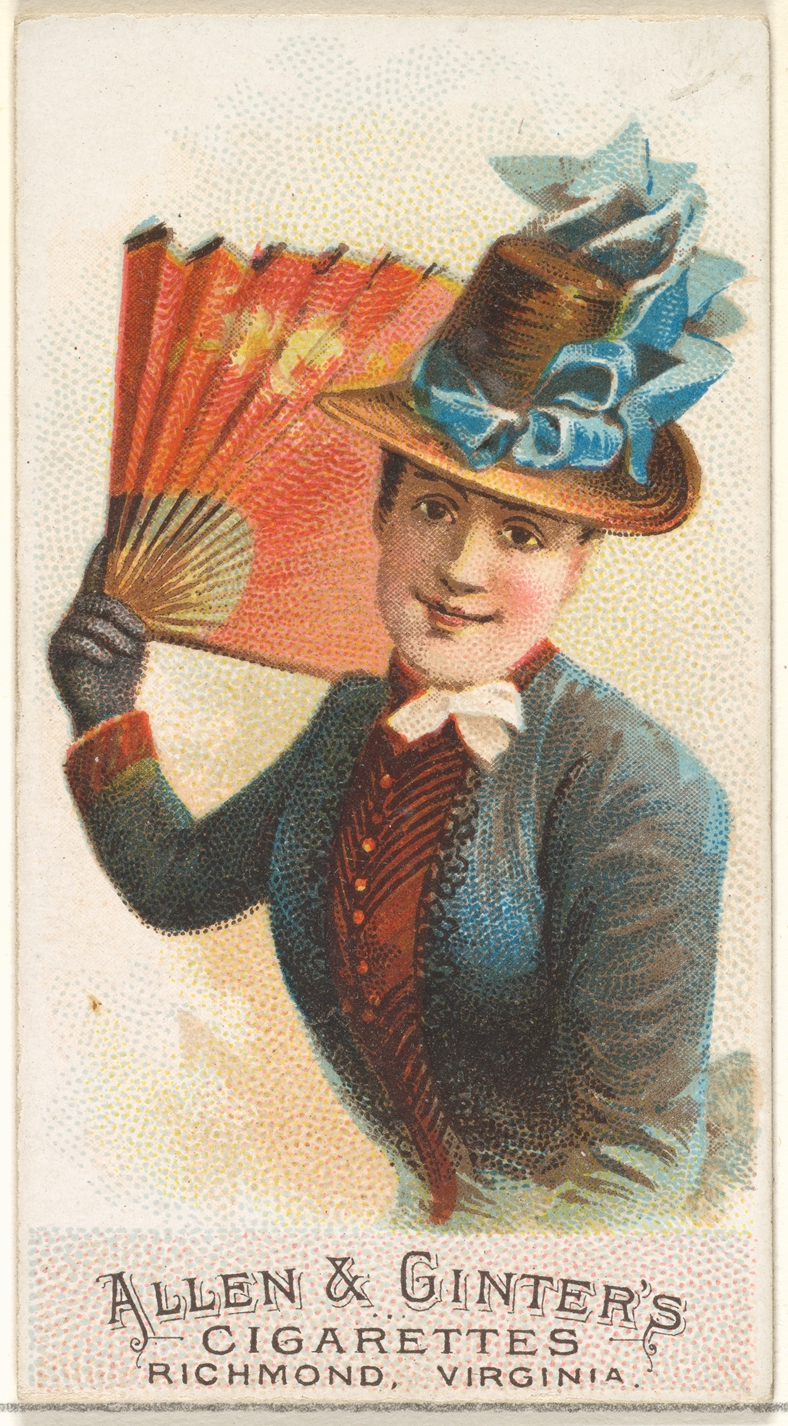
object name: print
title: Plate 3, from the Fans of the Period series (N7) for Allen & Ginter Cigarettes Brands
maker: allen & ginter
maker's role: publisher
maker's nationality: american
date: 1889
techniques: color lithograph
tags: fans,women